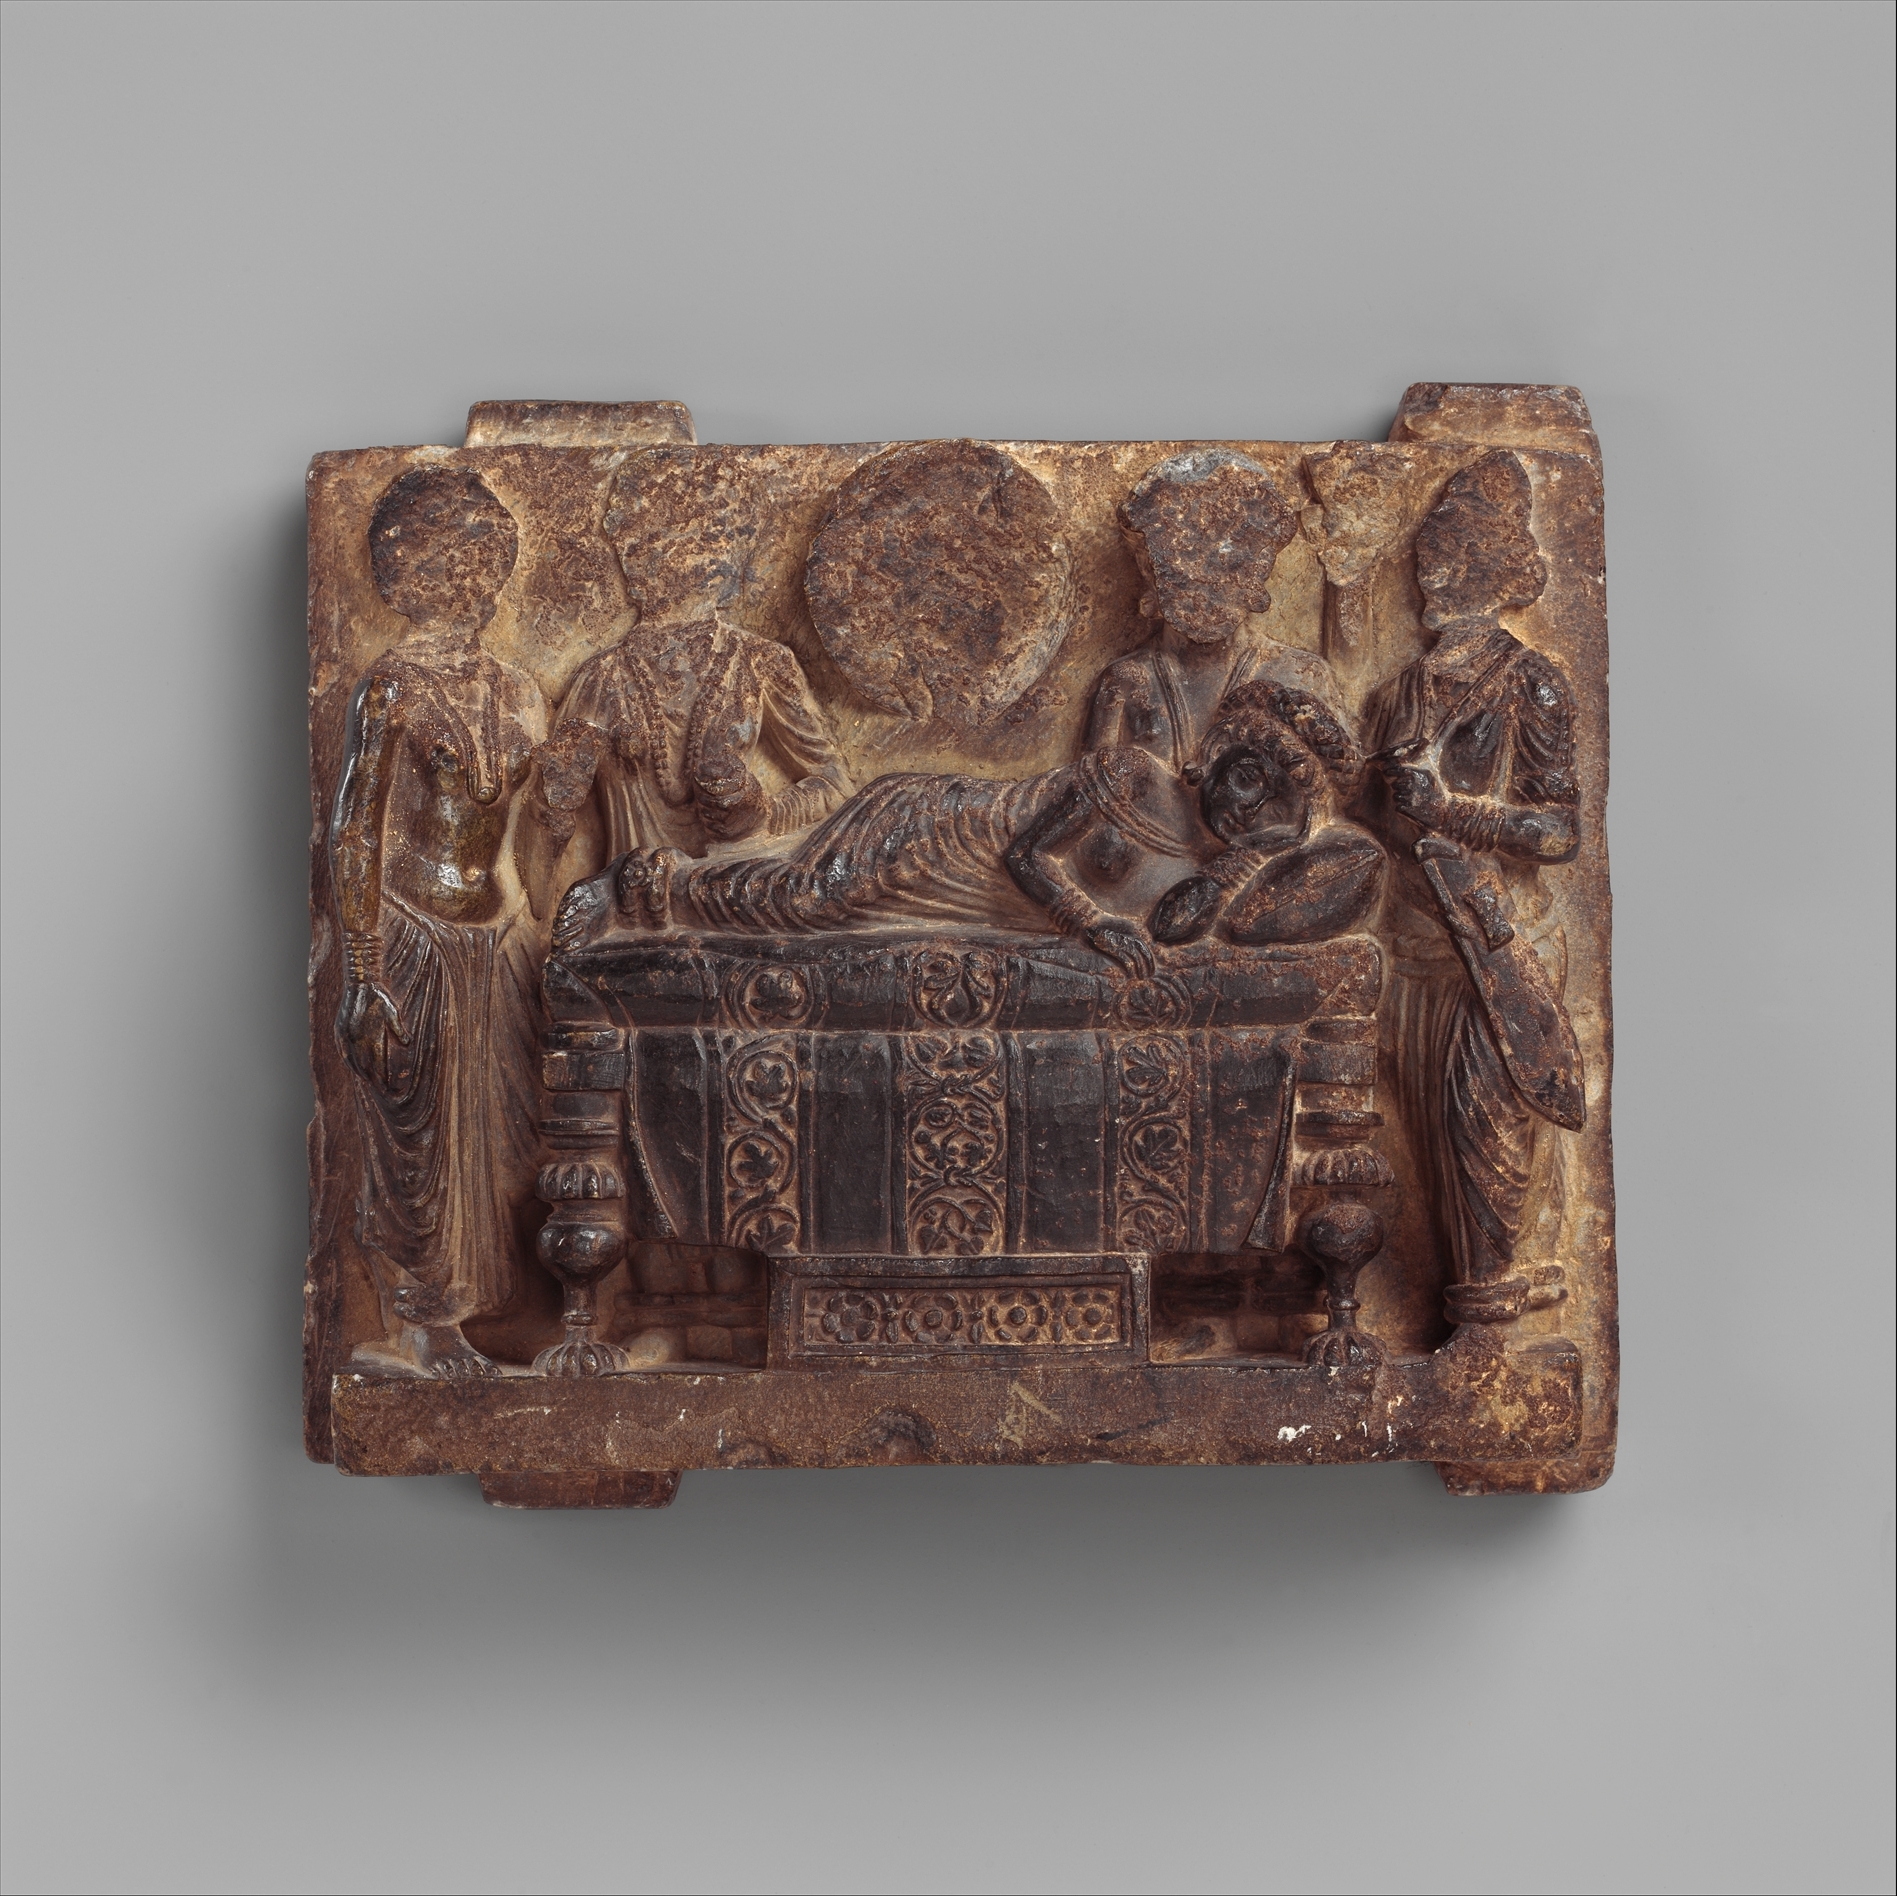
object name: relief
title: The Dream of Queen Maya (the Buddha's Conception)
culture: gandhara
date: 101-200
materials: stone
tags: gandhara,sleeping,women,buddhism,beds